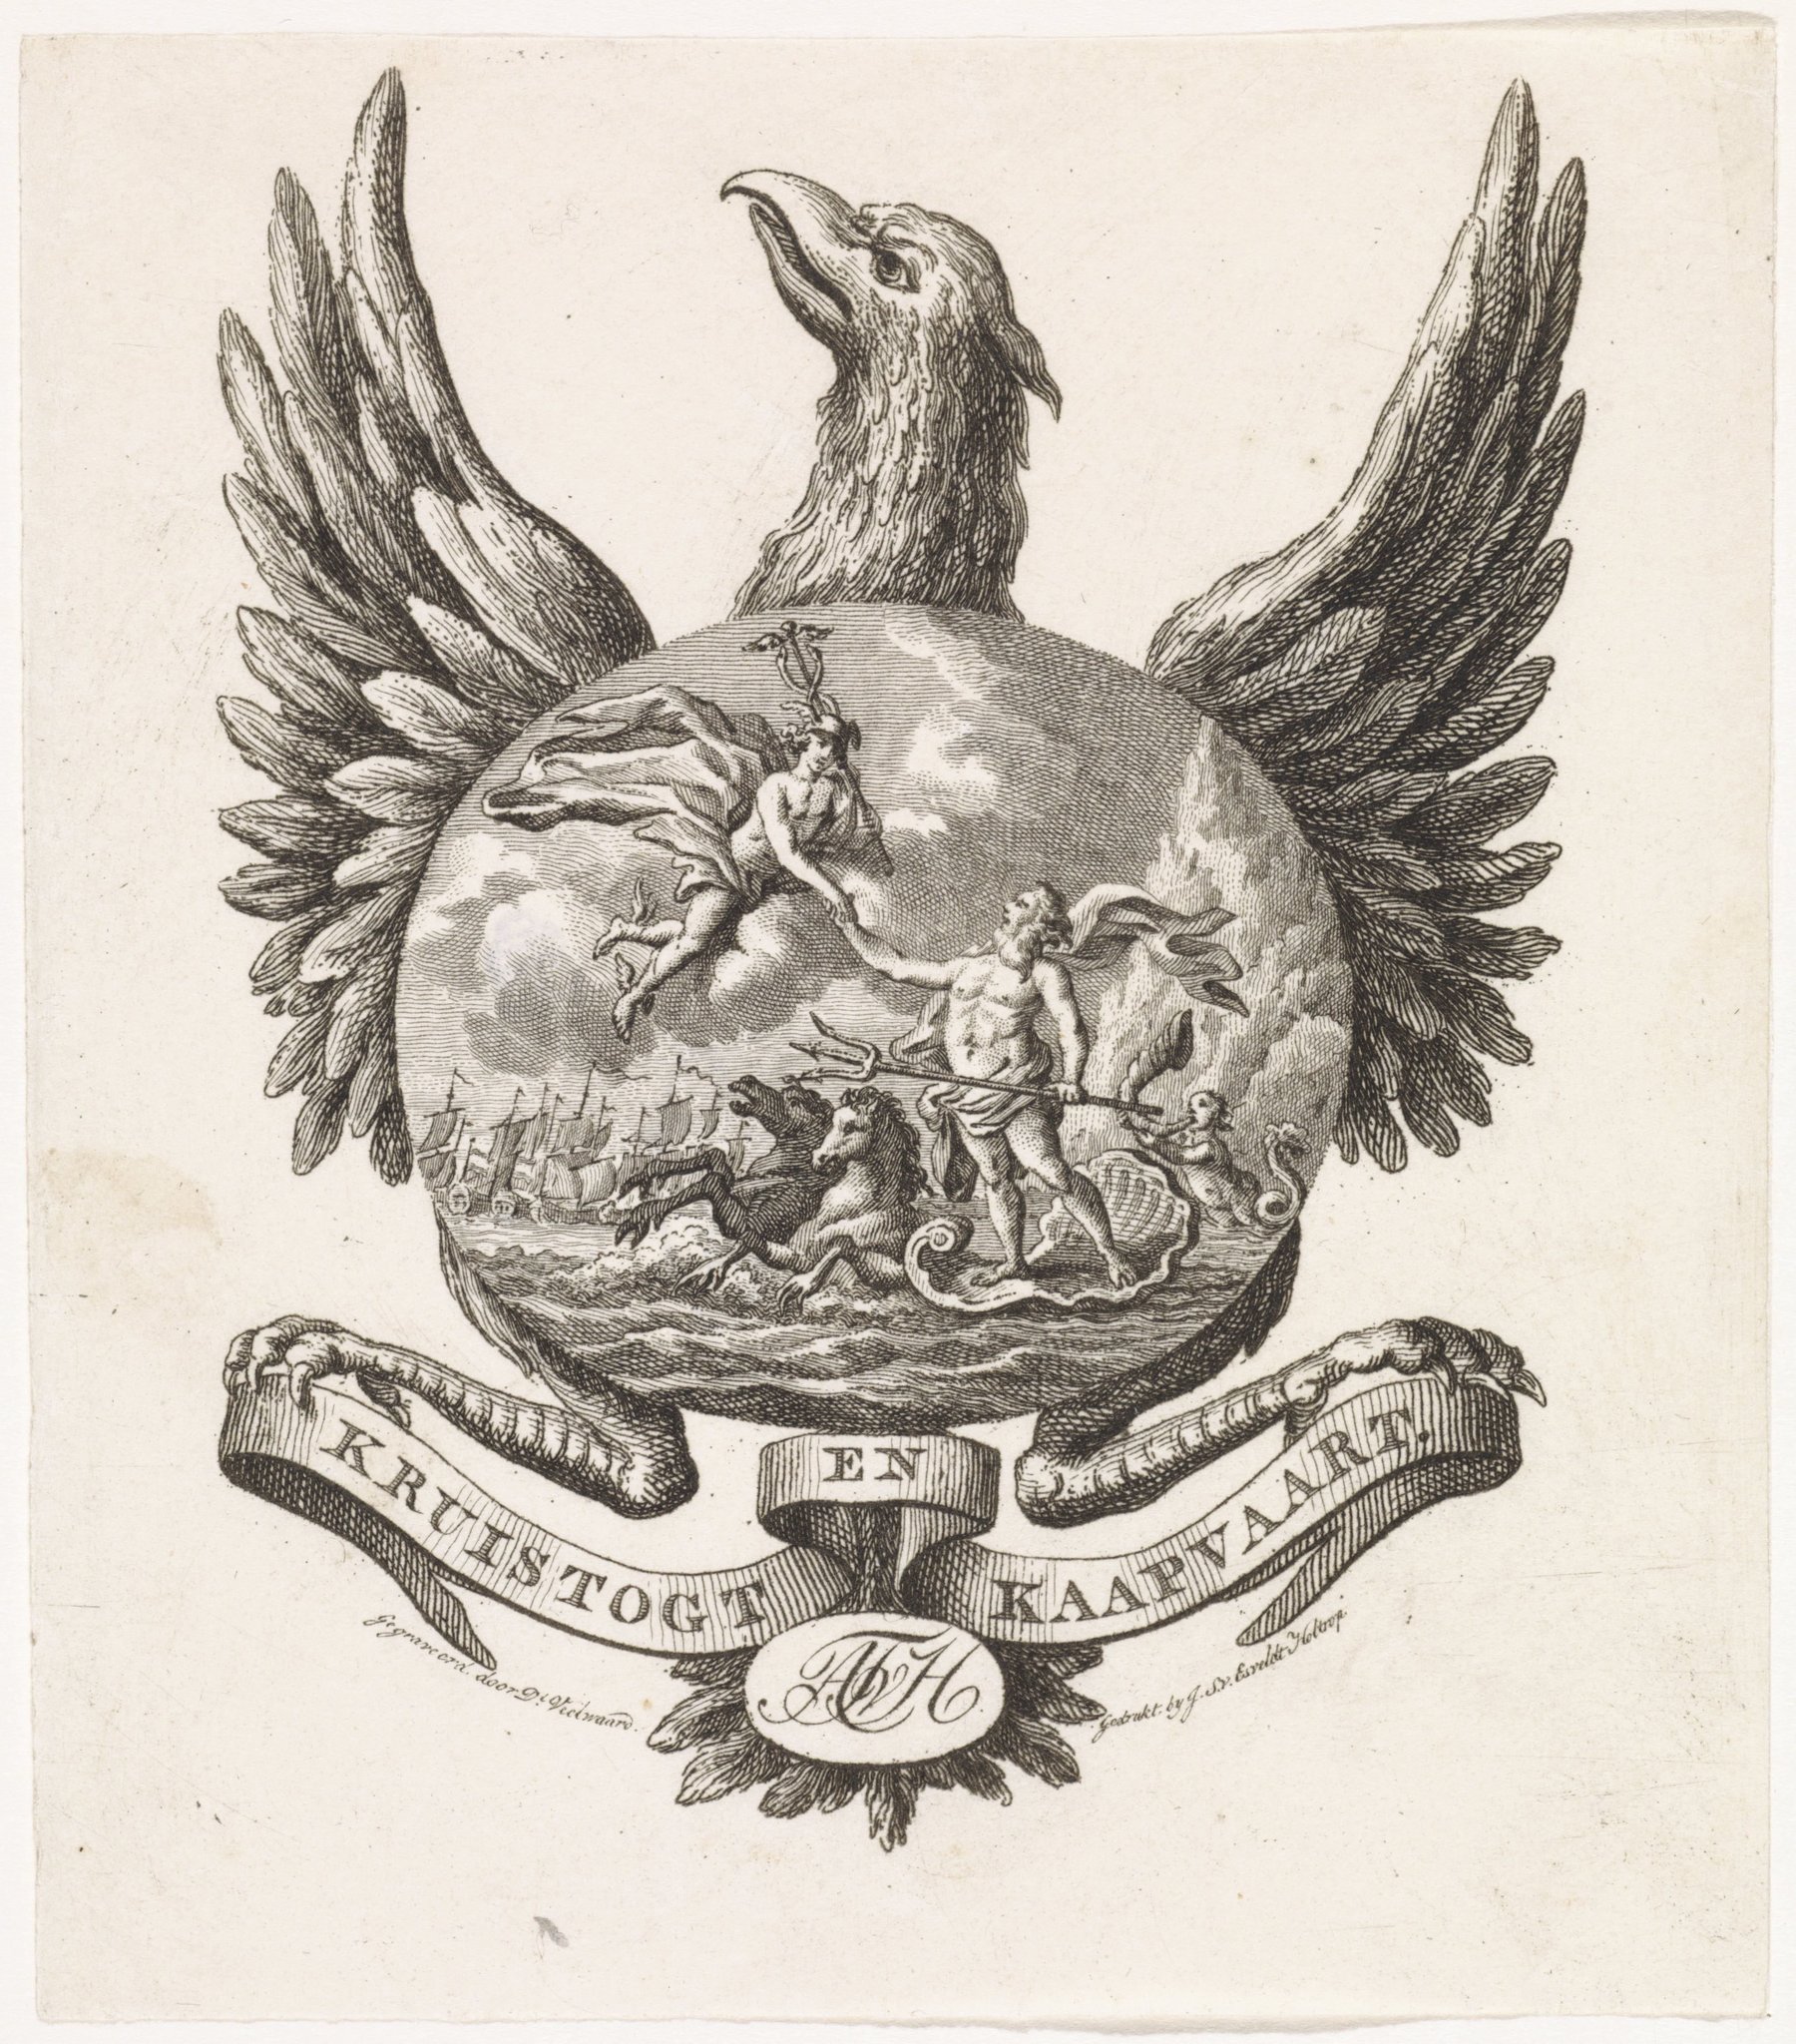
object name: print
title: Kruistogt en Kaapvaart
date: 1776-1851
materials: paper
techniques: engraving, etching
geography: amsterdam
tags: (story of) neptune (poseidon), sea-horse, hippocamp, 'hippocampus', (horse/fish) (mythological hybrid monster), (story of) mercury (hermes), predatory birds: eagle (+ animals used symbolically)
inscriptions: collector's mark: Lugt 2760, collector's mark: Lugt 2228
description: Een adelaar houdt een afbeelding vast van Neptunus en Mercurius die elkaar de hand schudden. Daaronder een banderol en daaronder de letters: AJvH.